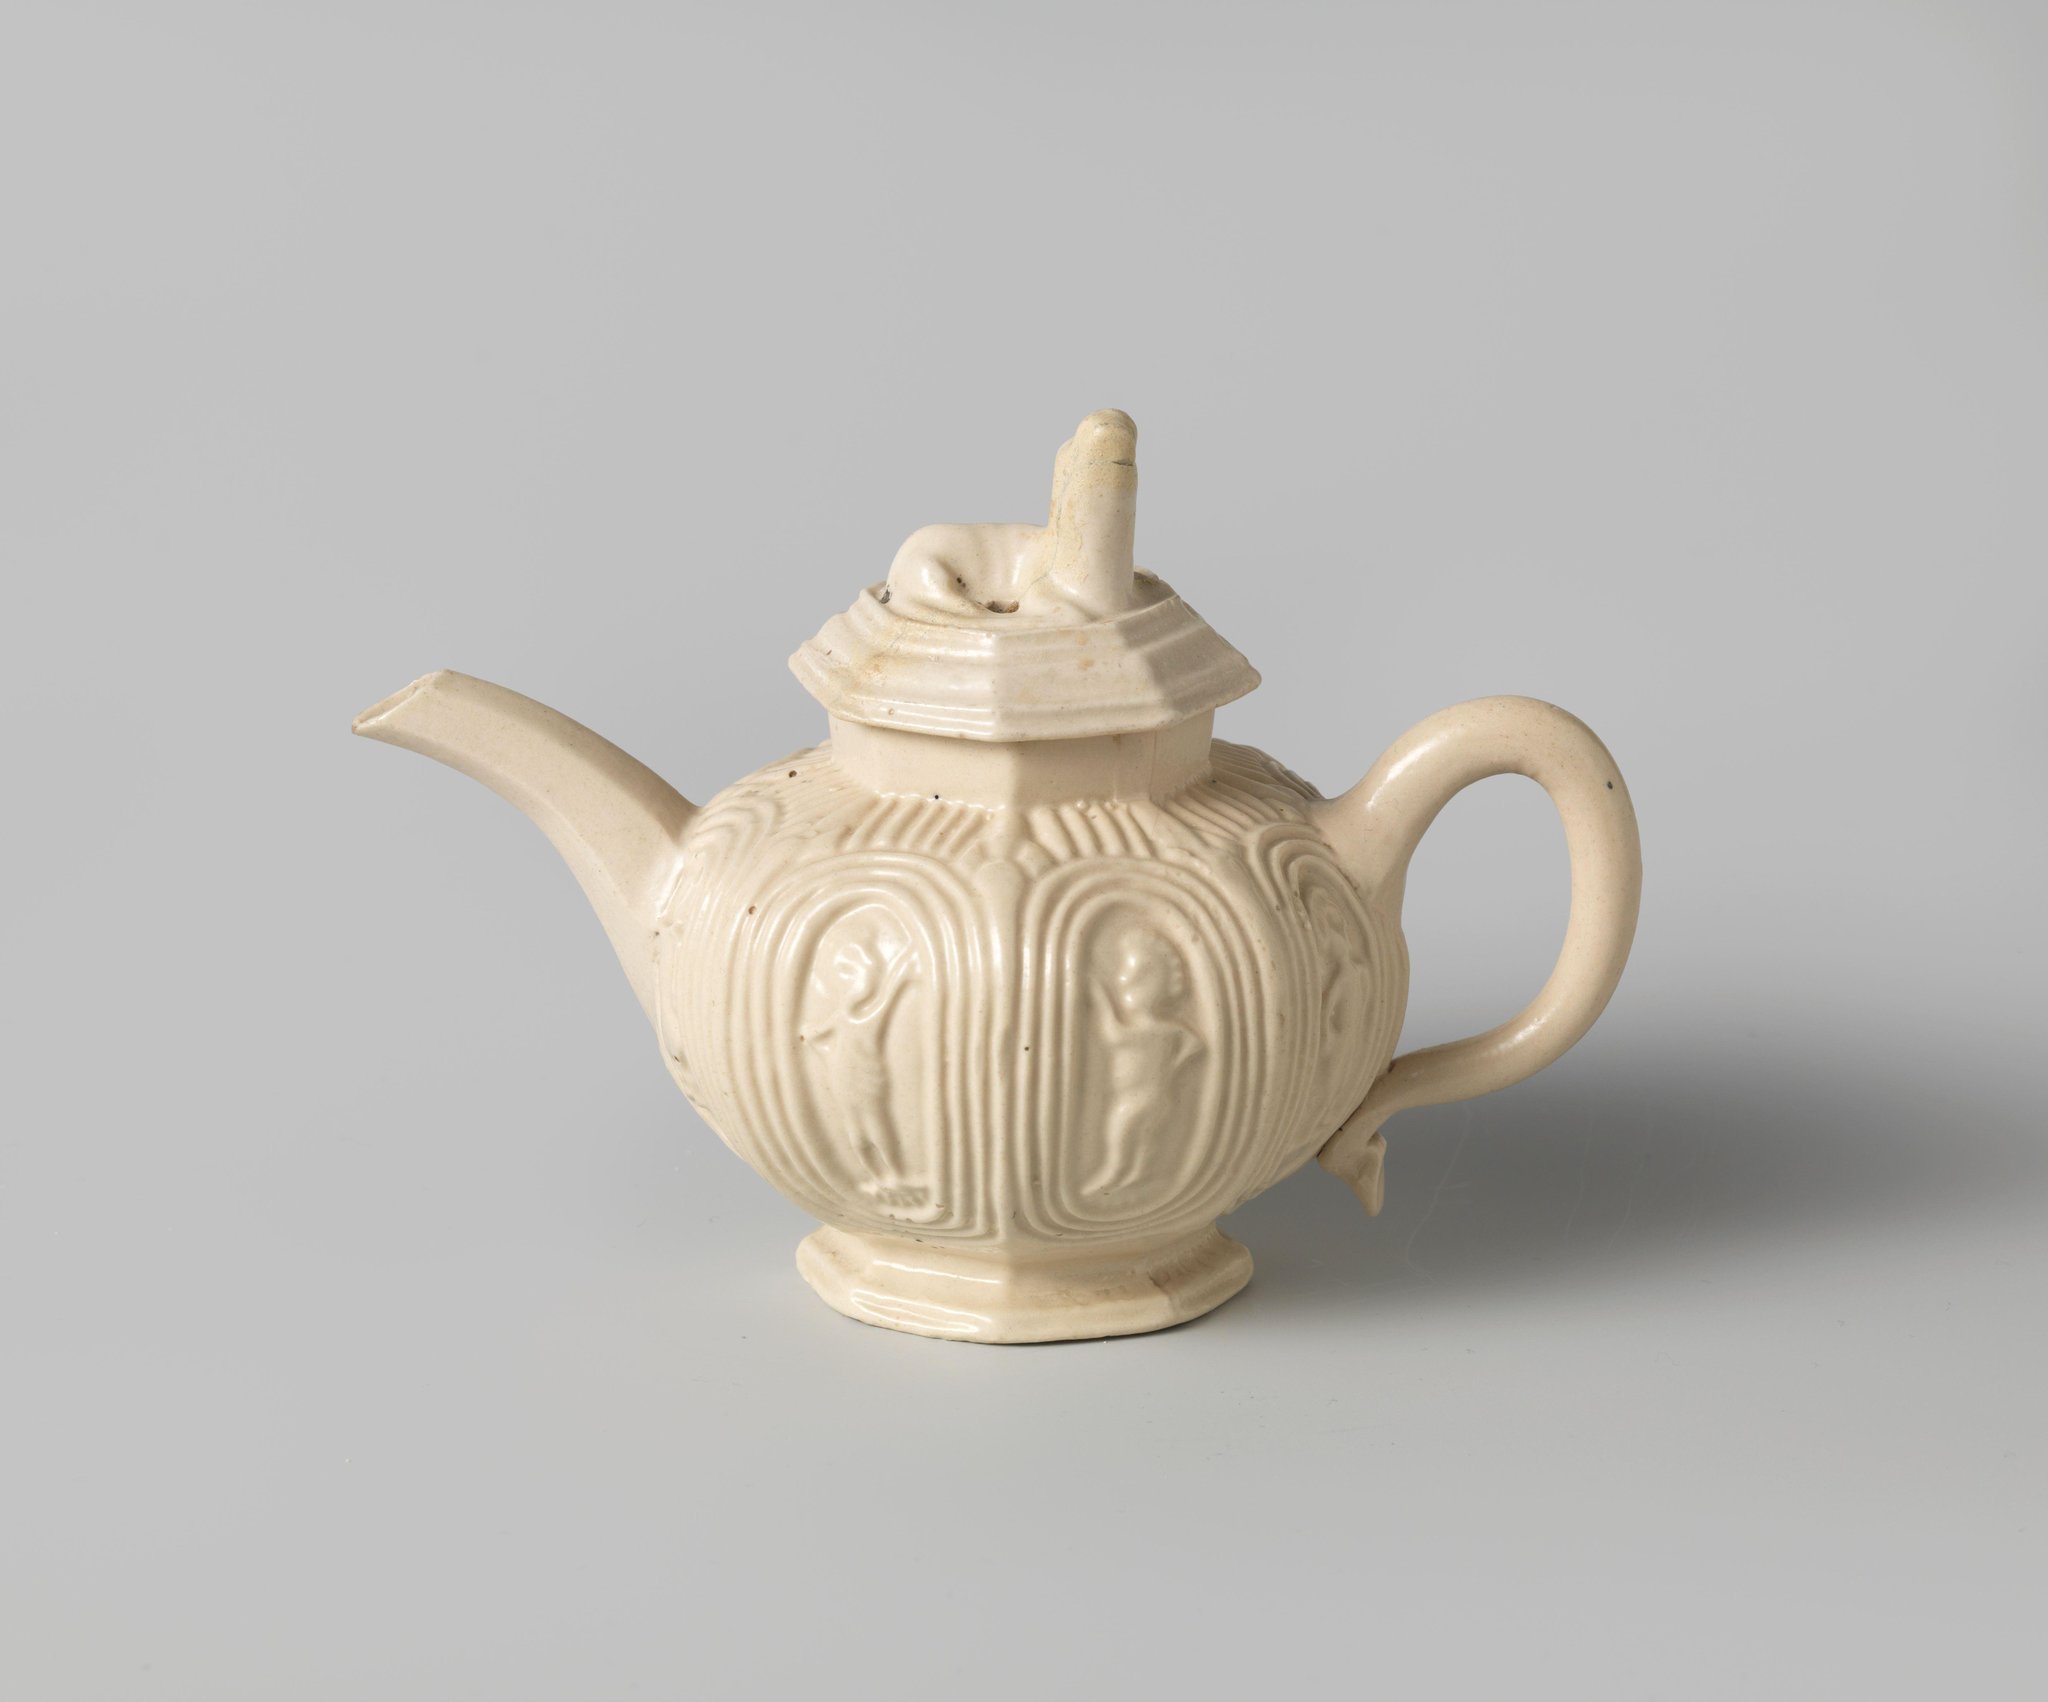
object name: teapot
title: Deksel van theepot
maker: Anonymous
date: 1740-1760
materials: stoneware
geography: england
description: Een achthoekig deksel, het deksel heeft een liggend dier (zeehond ?) als knop.